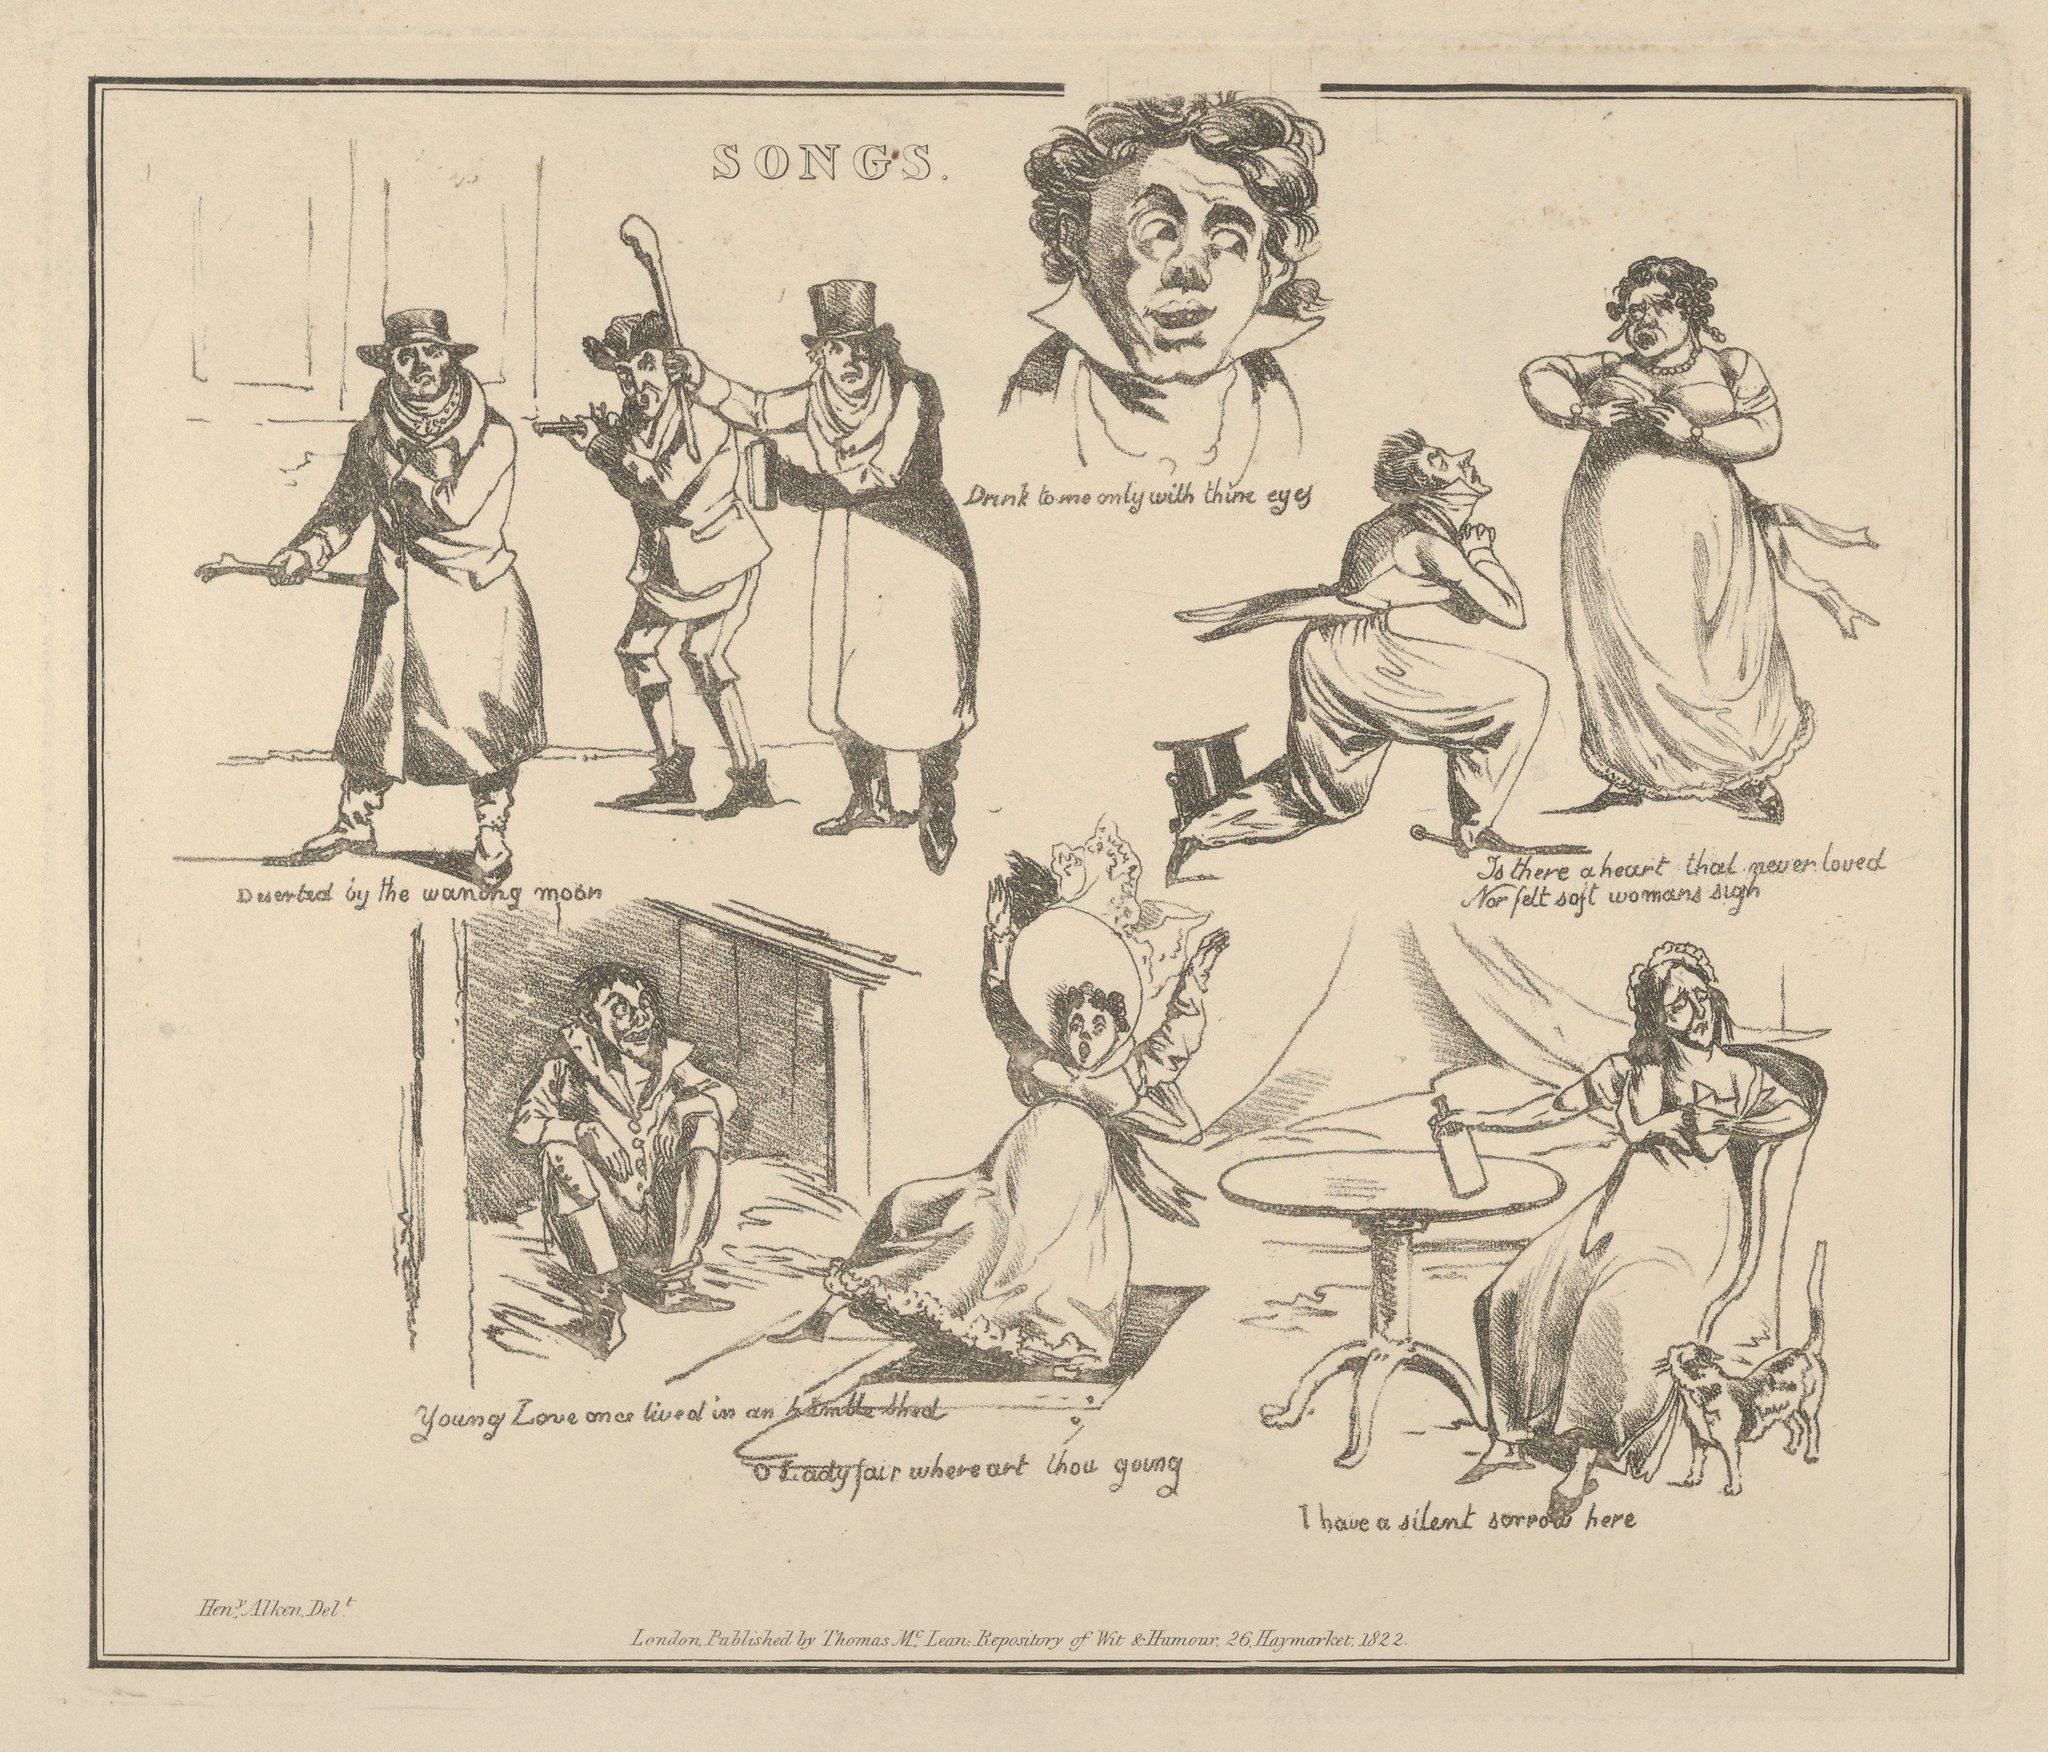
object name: print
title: Songs: "Deserted by the waning moon..."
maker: henry alken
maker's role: artist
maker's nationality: british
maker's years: 1785-1851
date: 1822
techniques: etching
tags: satire,weapons,men,women,singing,cats,drinking